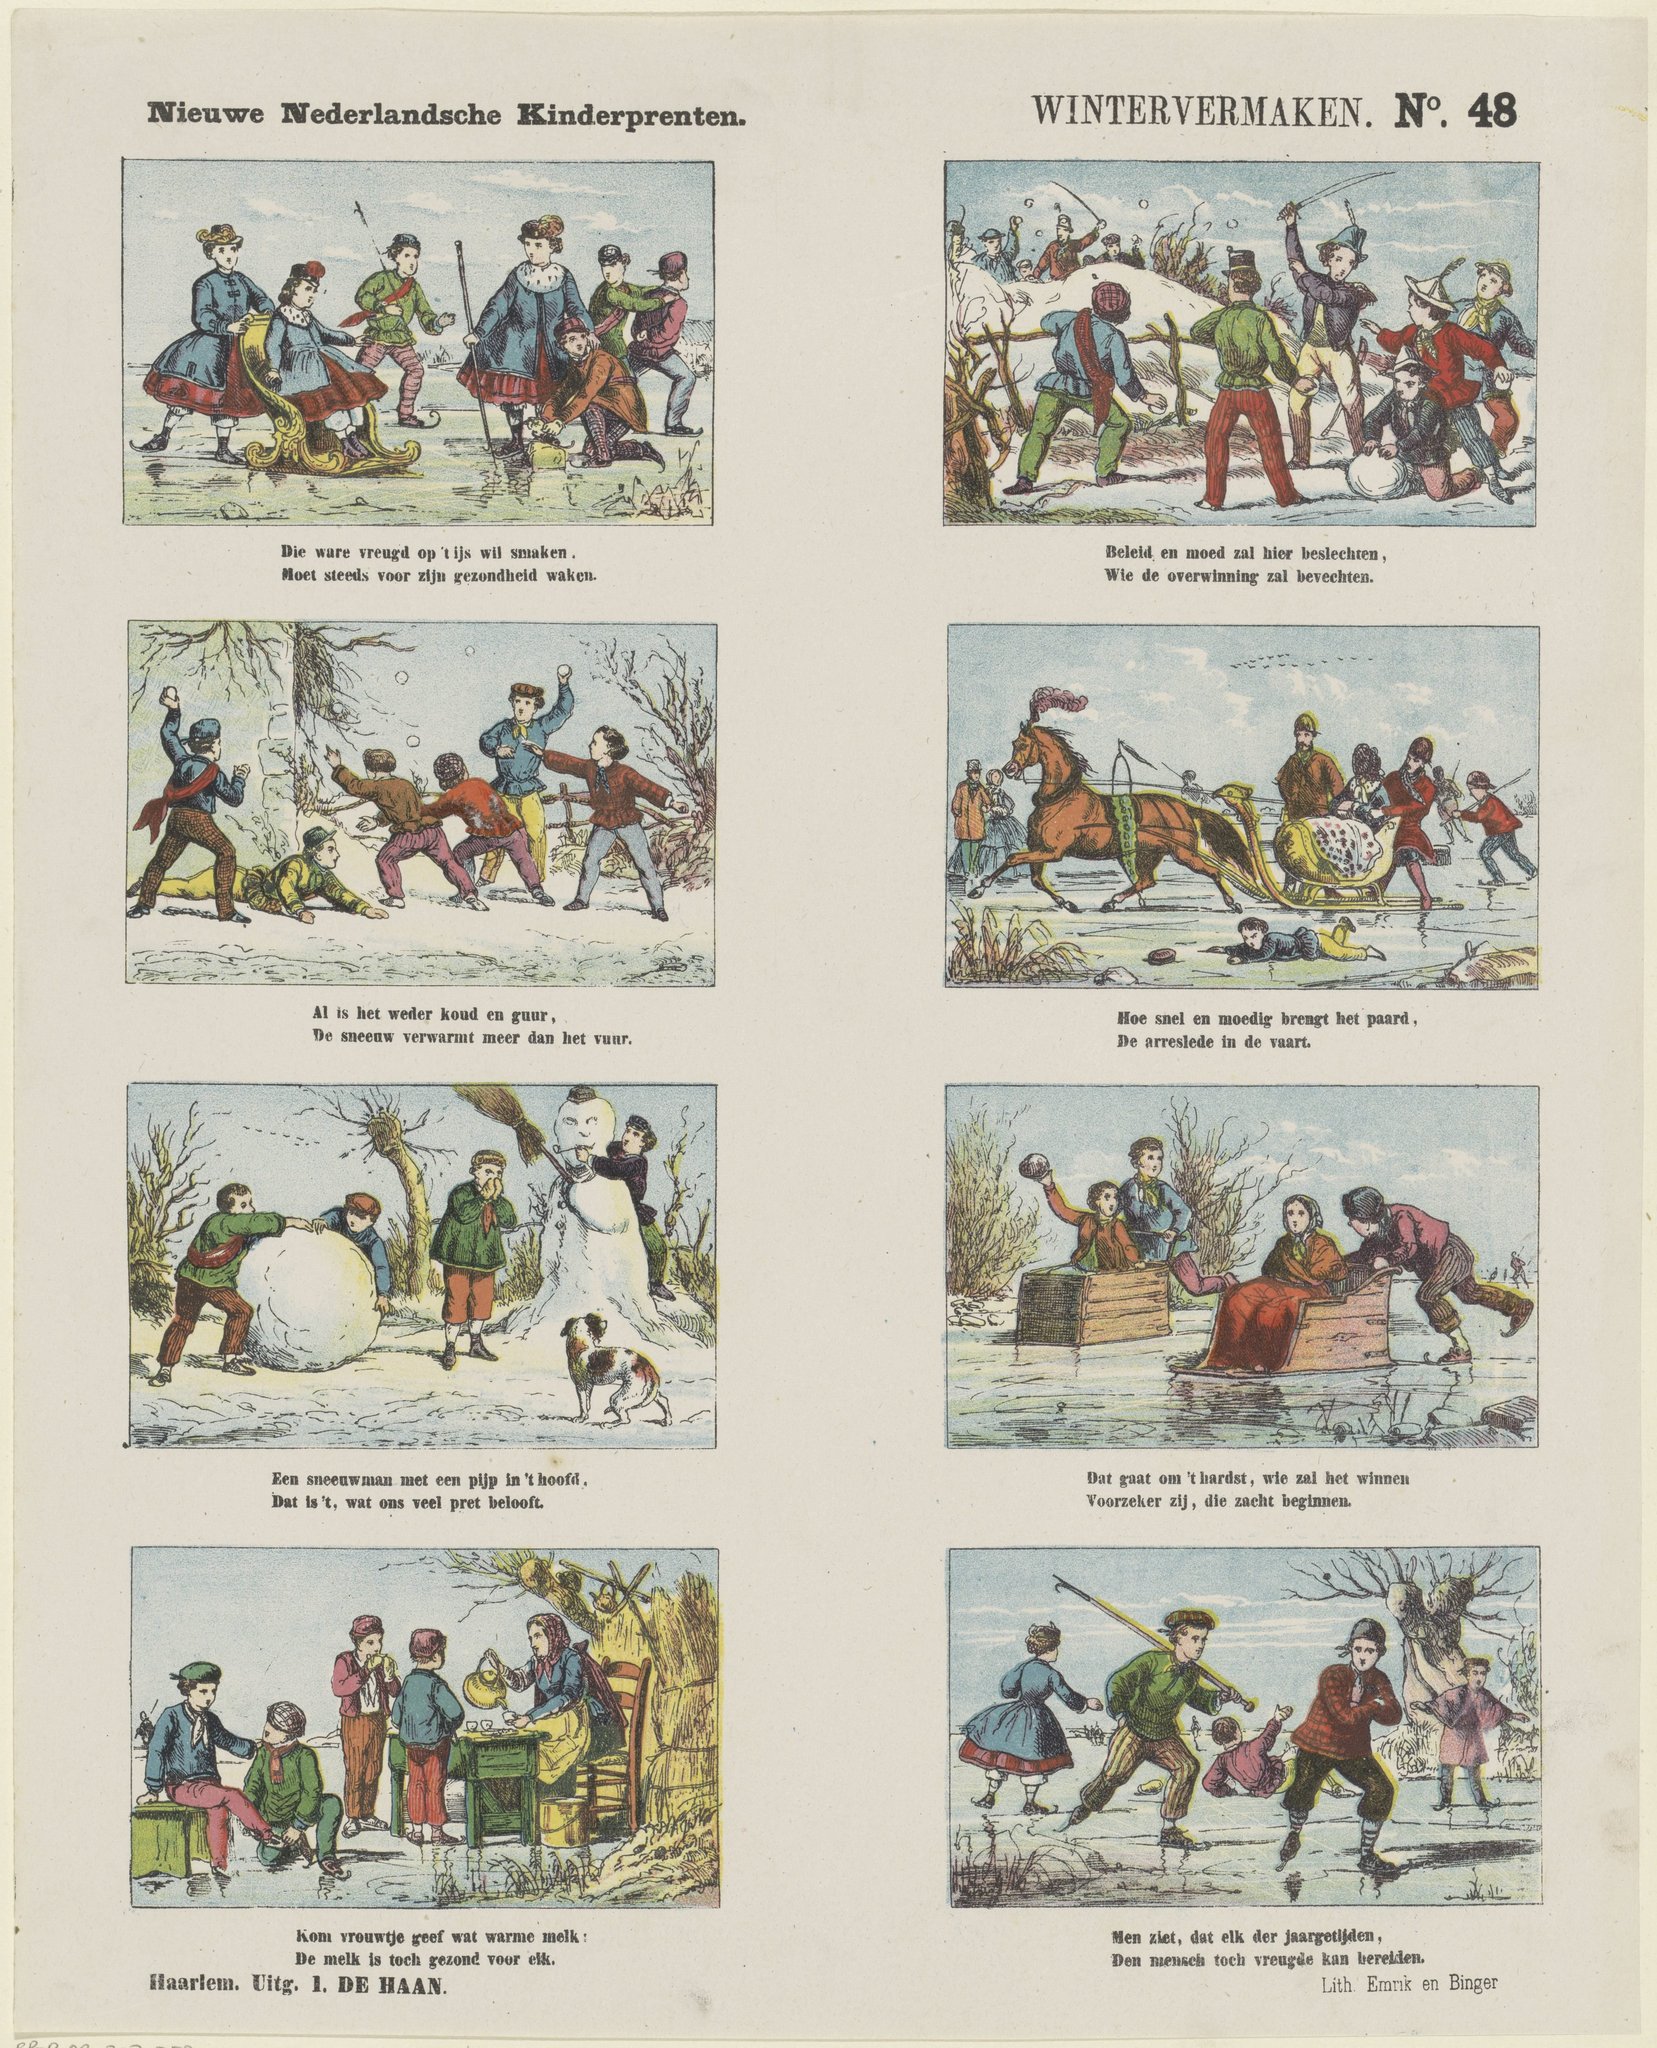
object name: print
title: Nieuwe Nederlandsche kinderprenten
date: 1875-1903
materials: paper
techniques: lithograph, letterpress printing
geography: haarlem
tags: (making a) snowman, skates (winter sports), throwing snowballs, rolling up a snowball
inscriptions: collector's mark: Lugt 2760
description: Blad met 8 voorstellingen van winteractiviteiten, waaronder sneeuwballen gooien, schaatsen en een sneeuwpop maken. Onder elke afbeelding een tweeregelig vers. Genummerd rechtsboven: No. 48.